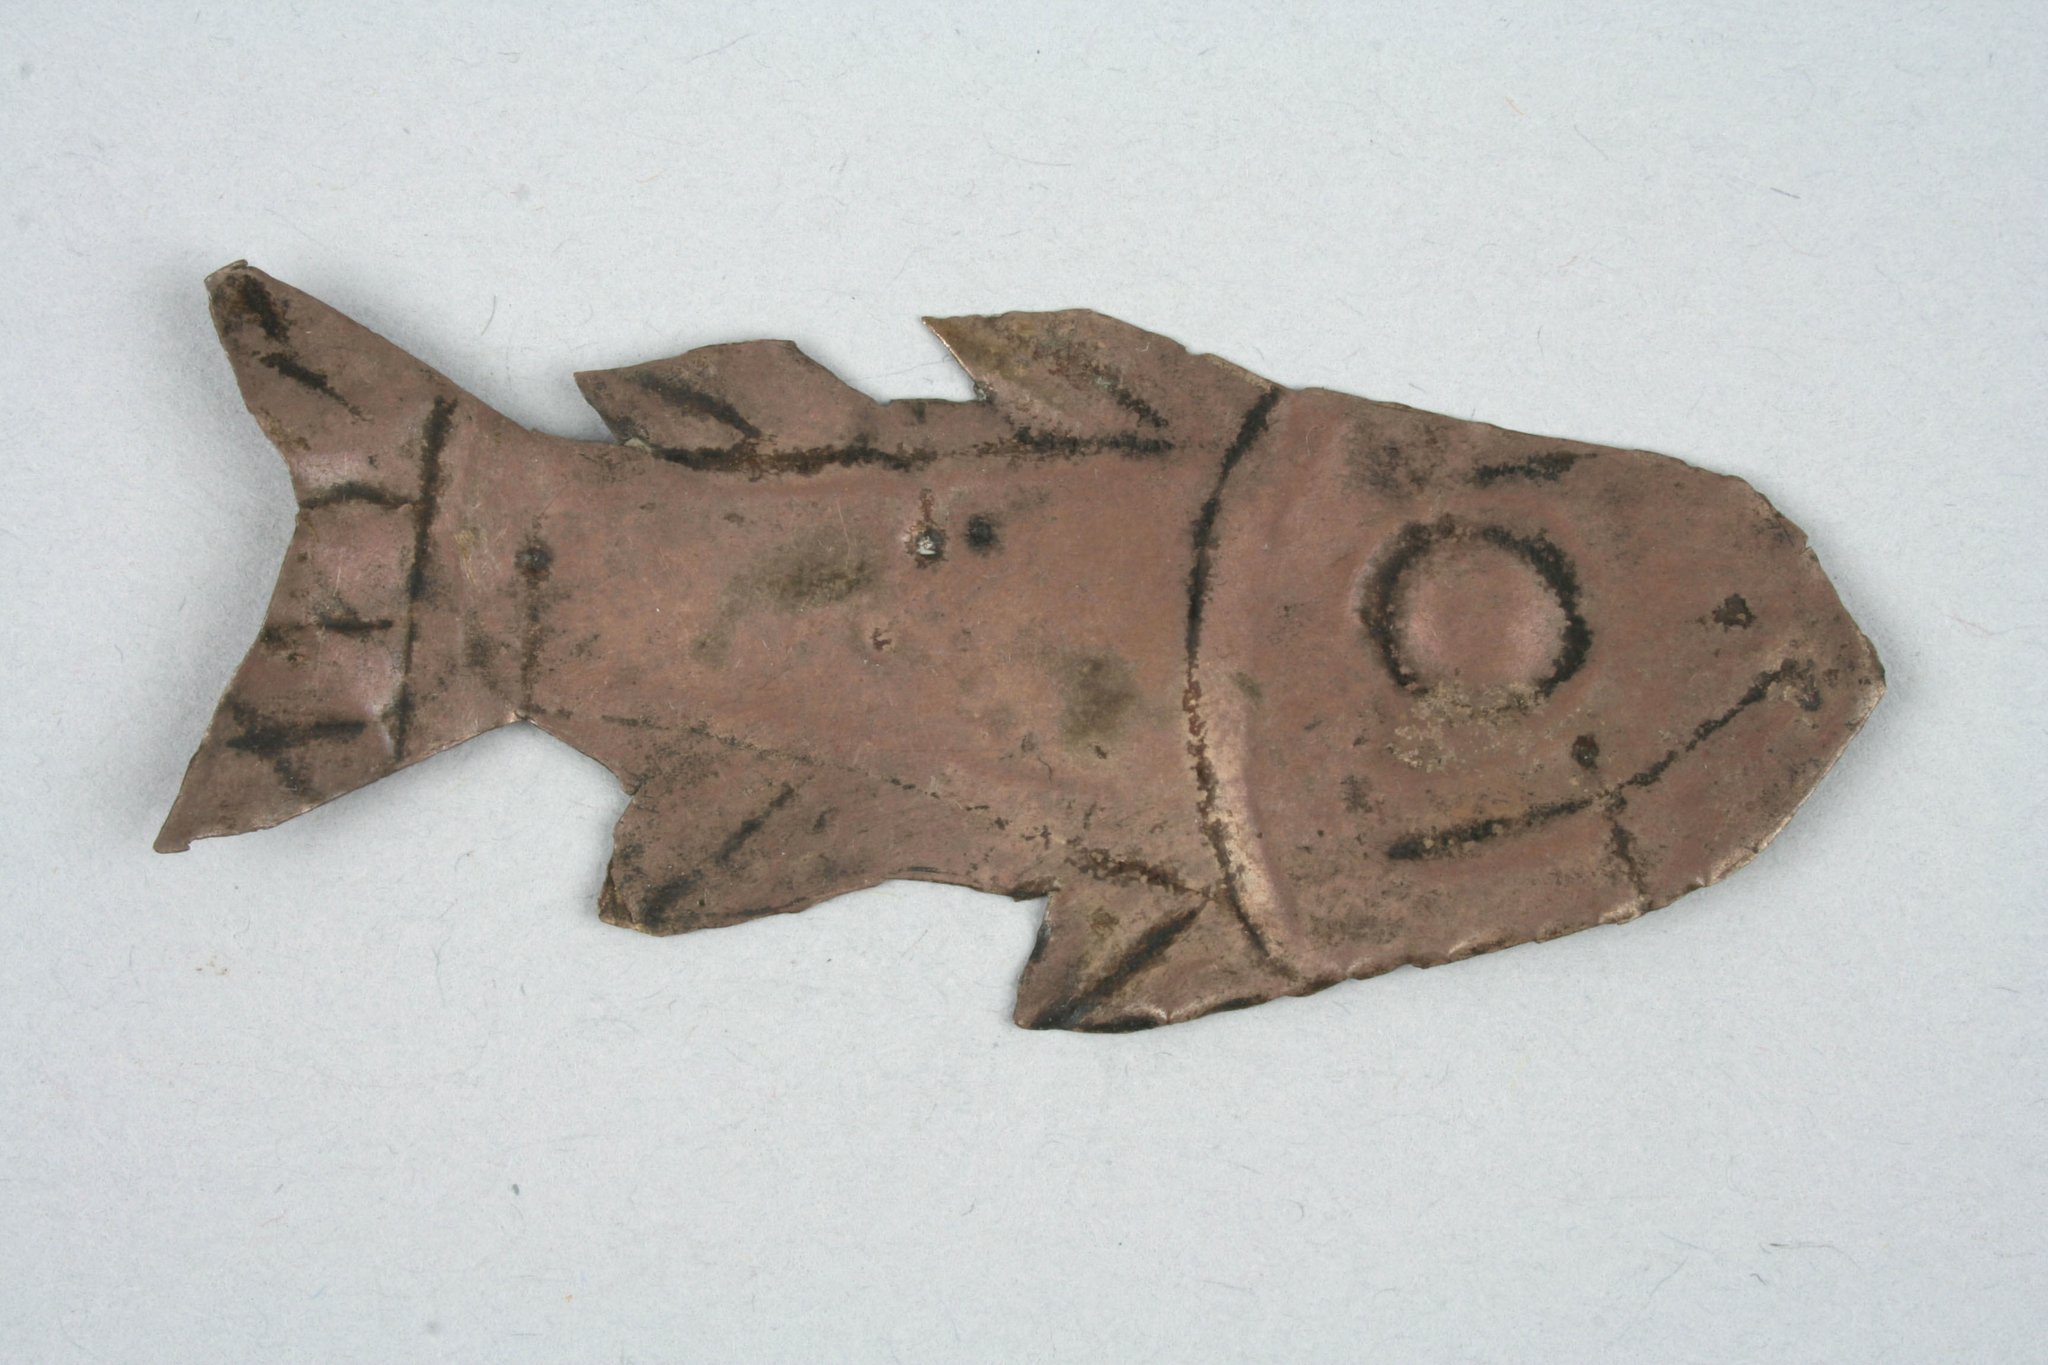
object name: costume ornament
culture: peruvian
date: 1001-1200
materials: silver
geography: peru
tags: fish